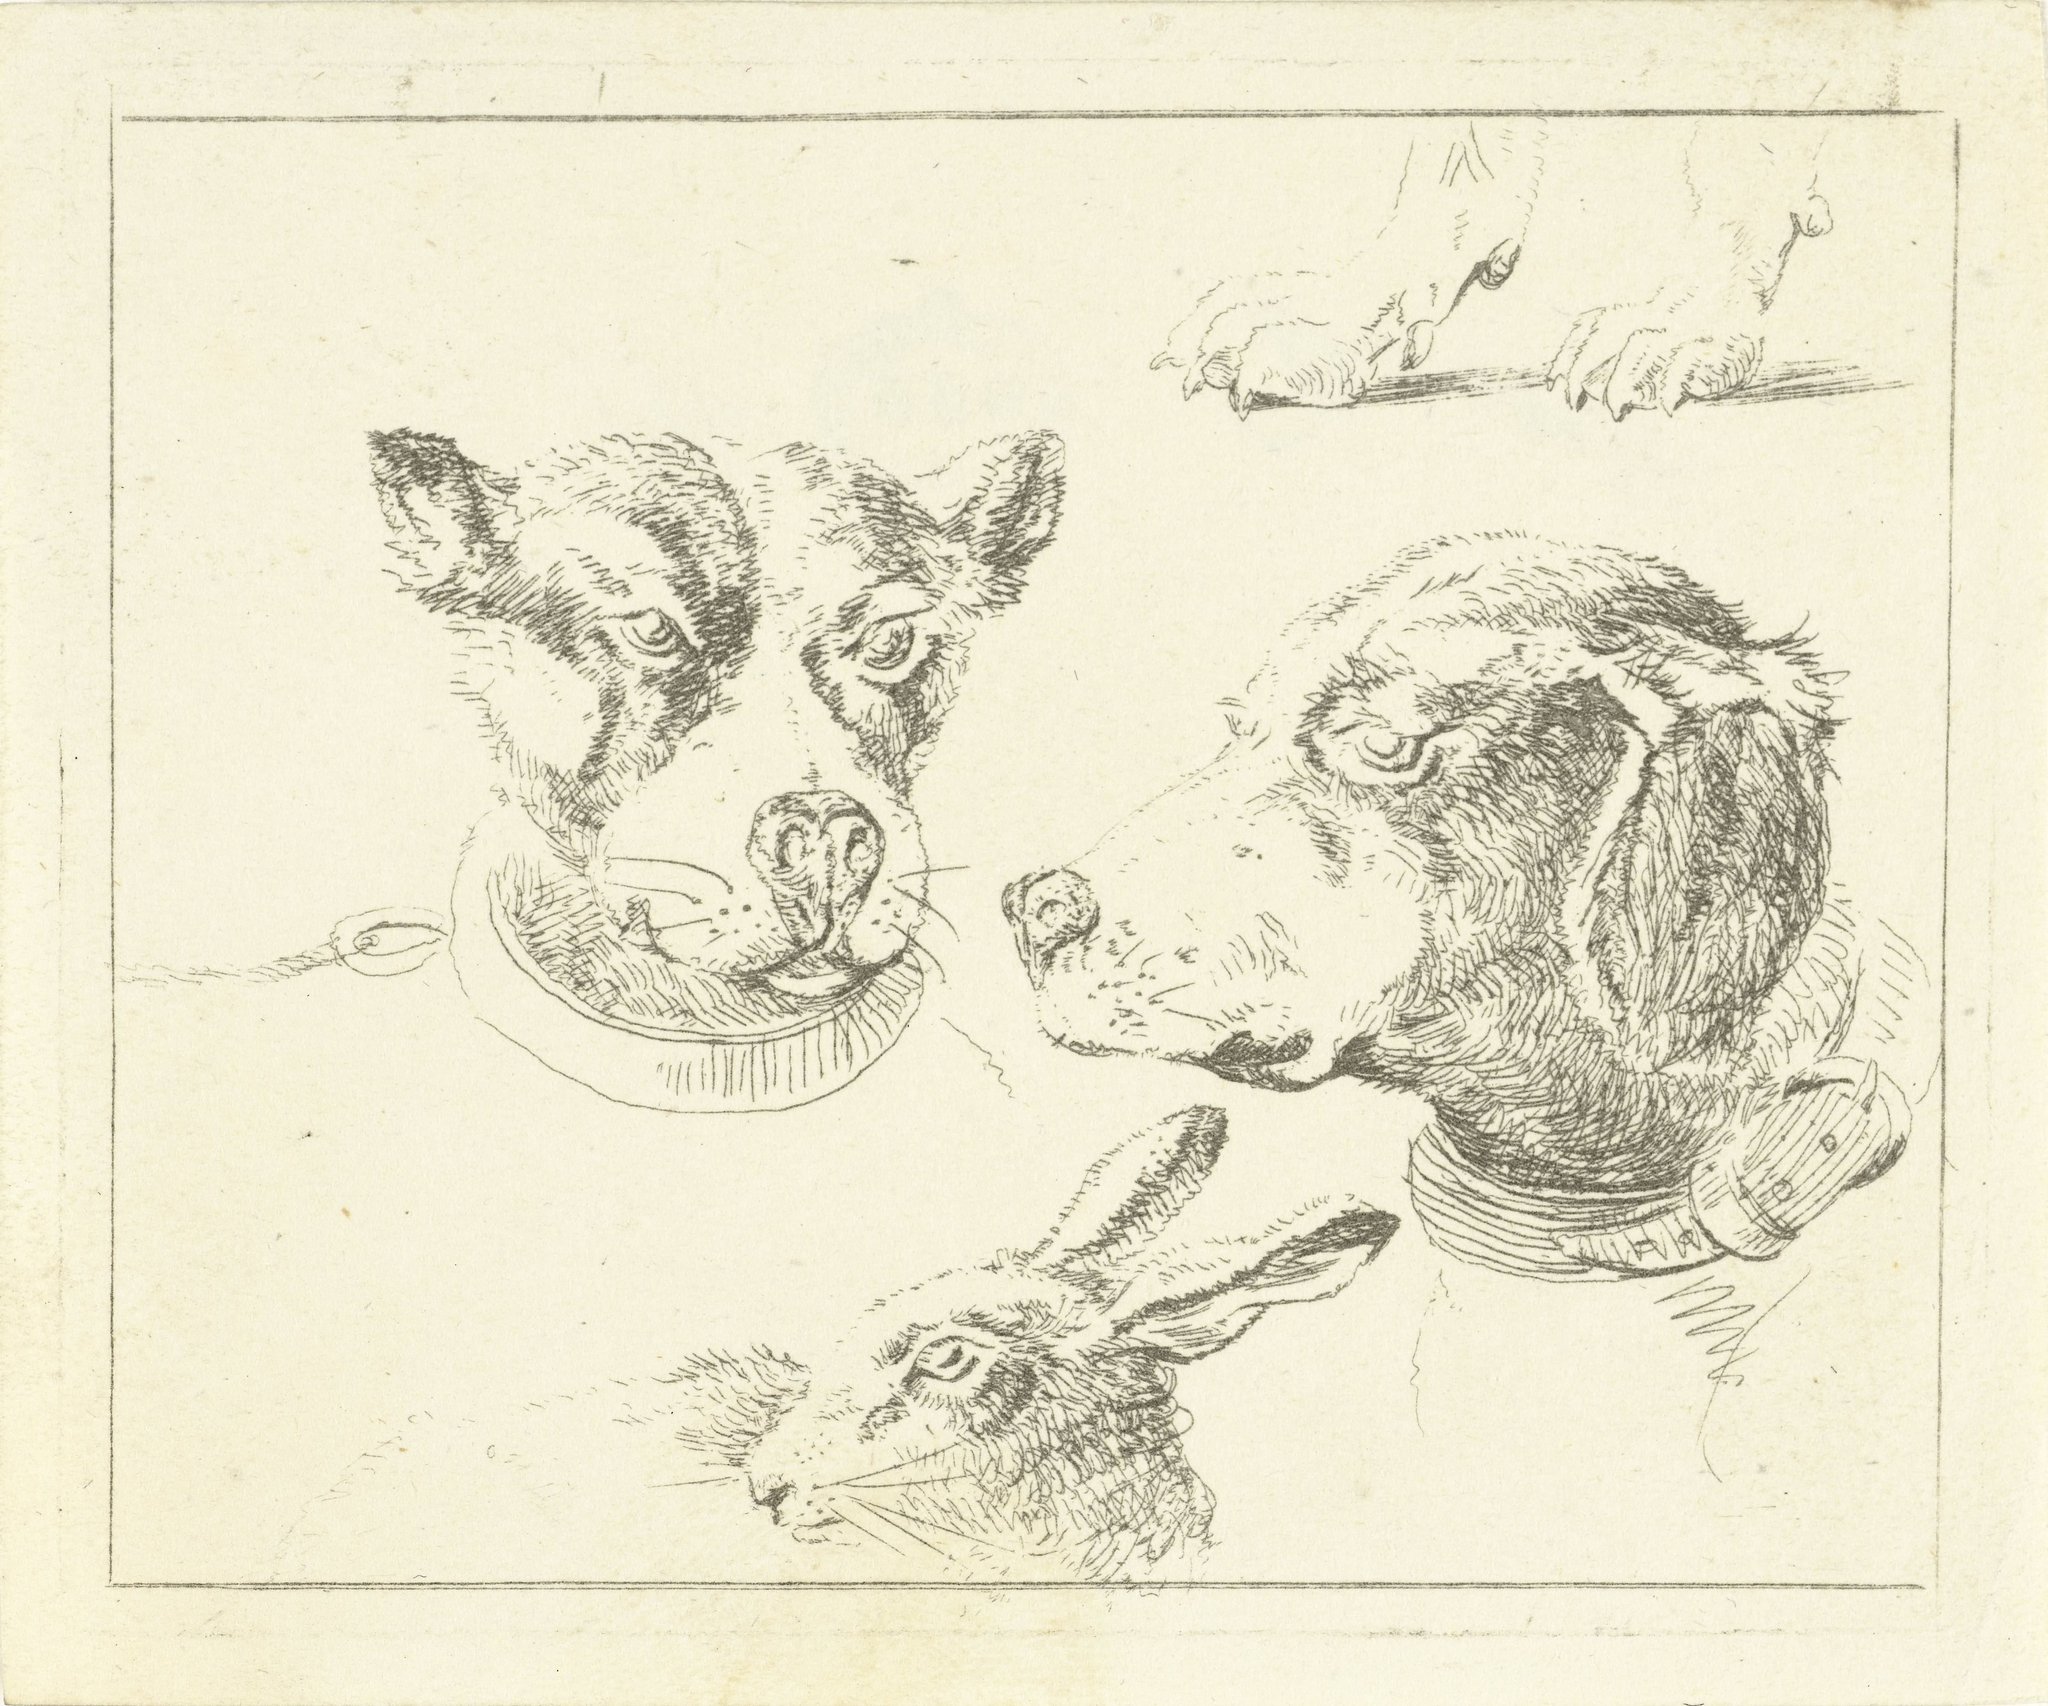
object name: print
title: Studieblad met twee hondenkoppen, poten van hond en kop van haas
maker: jan dasveldt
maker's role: draughtsman, print maker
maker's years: 1770-1855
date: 1780-1855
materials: paper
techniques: printmaking, etching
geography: amsterdam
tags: rodents: hare, dog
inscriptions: collector's mark: Lugt 1962, collector's mark: Lugt 2227